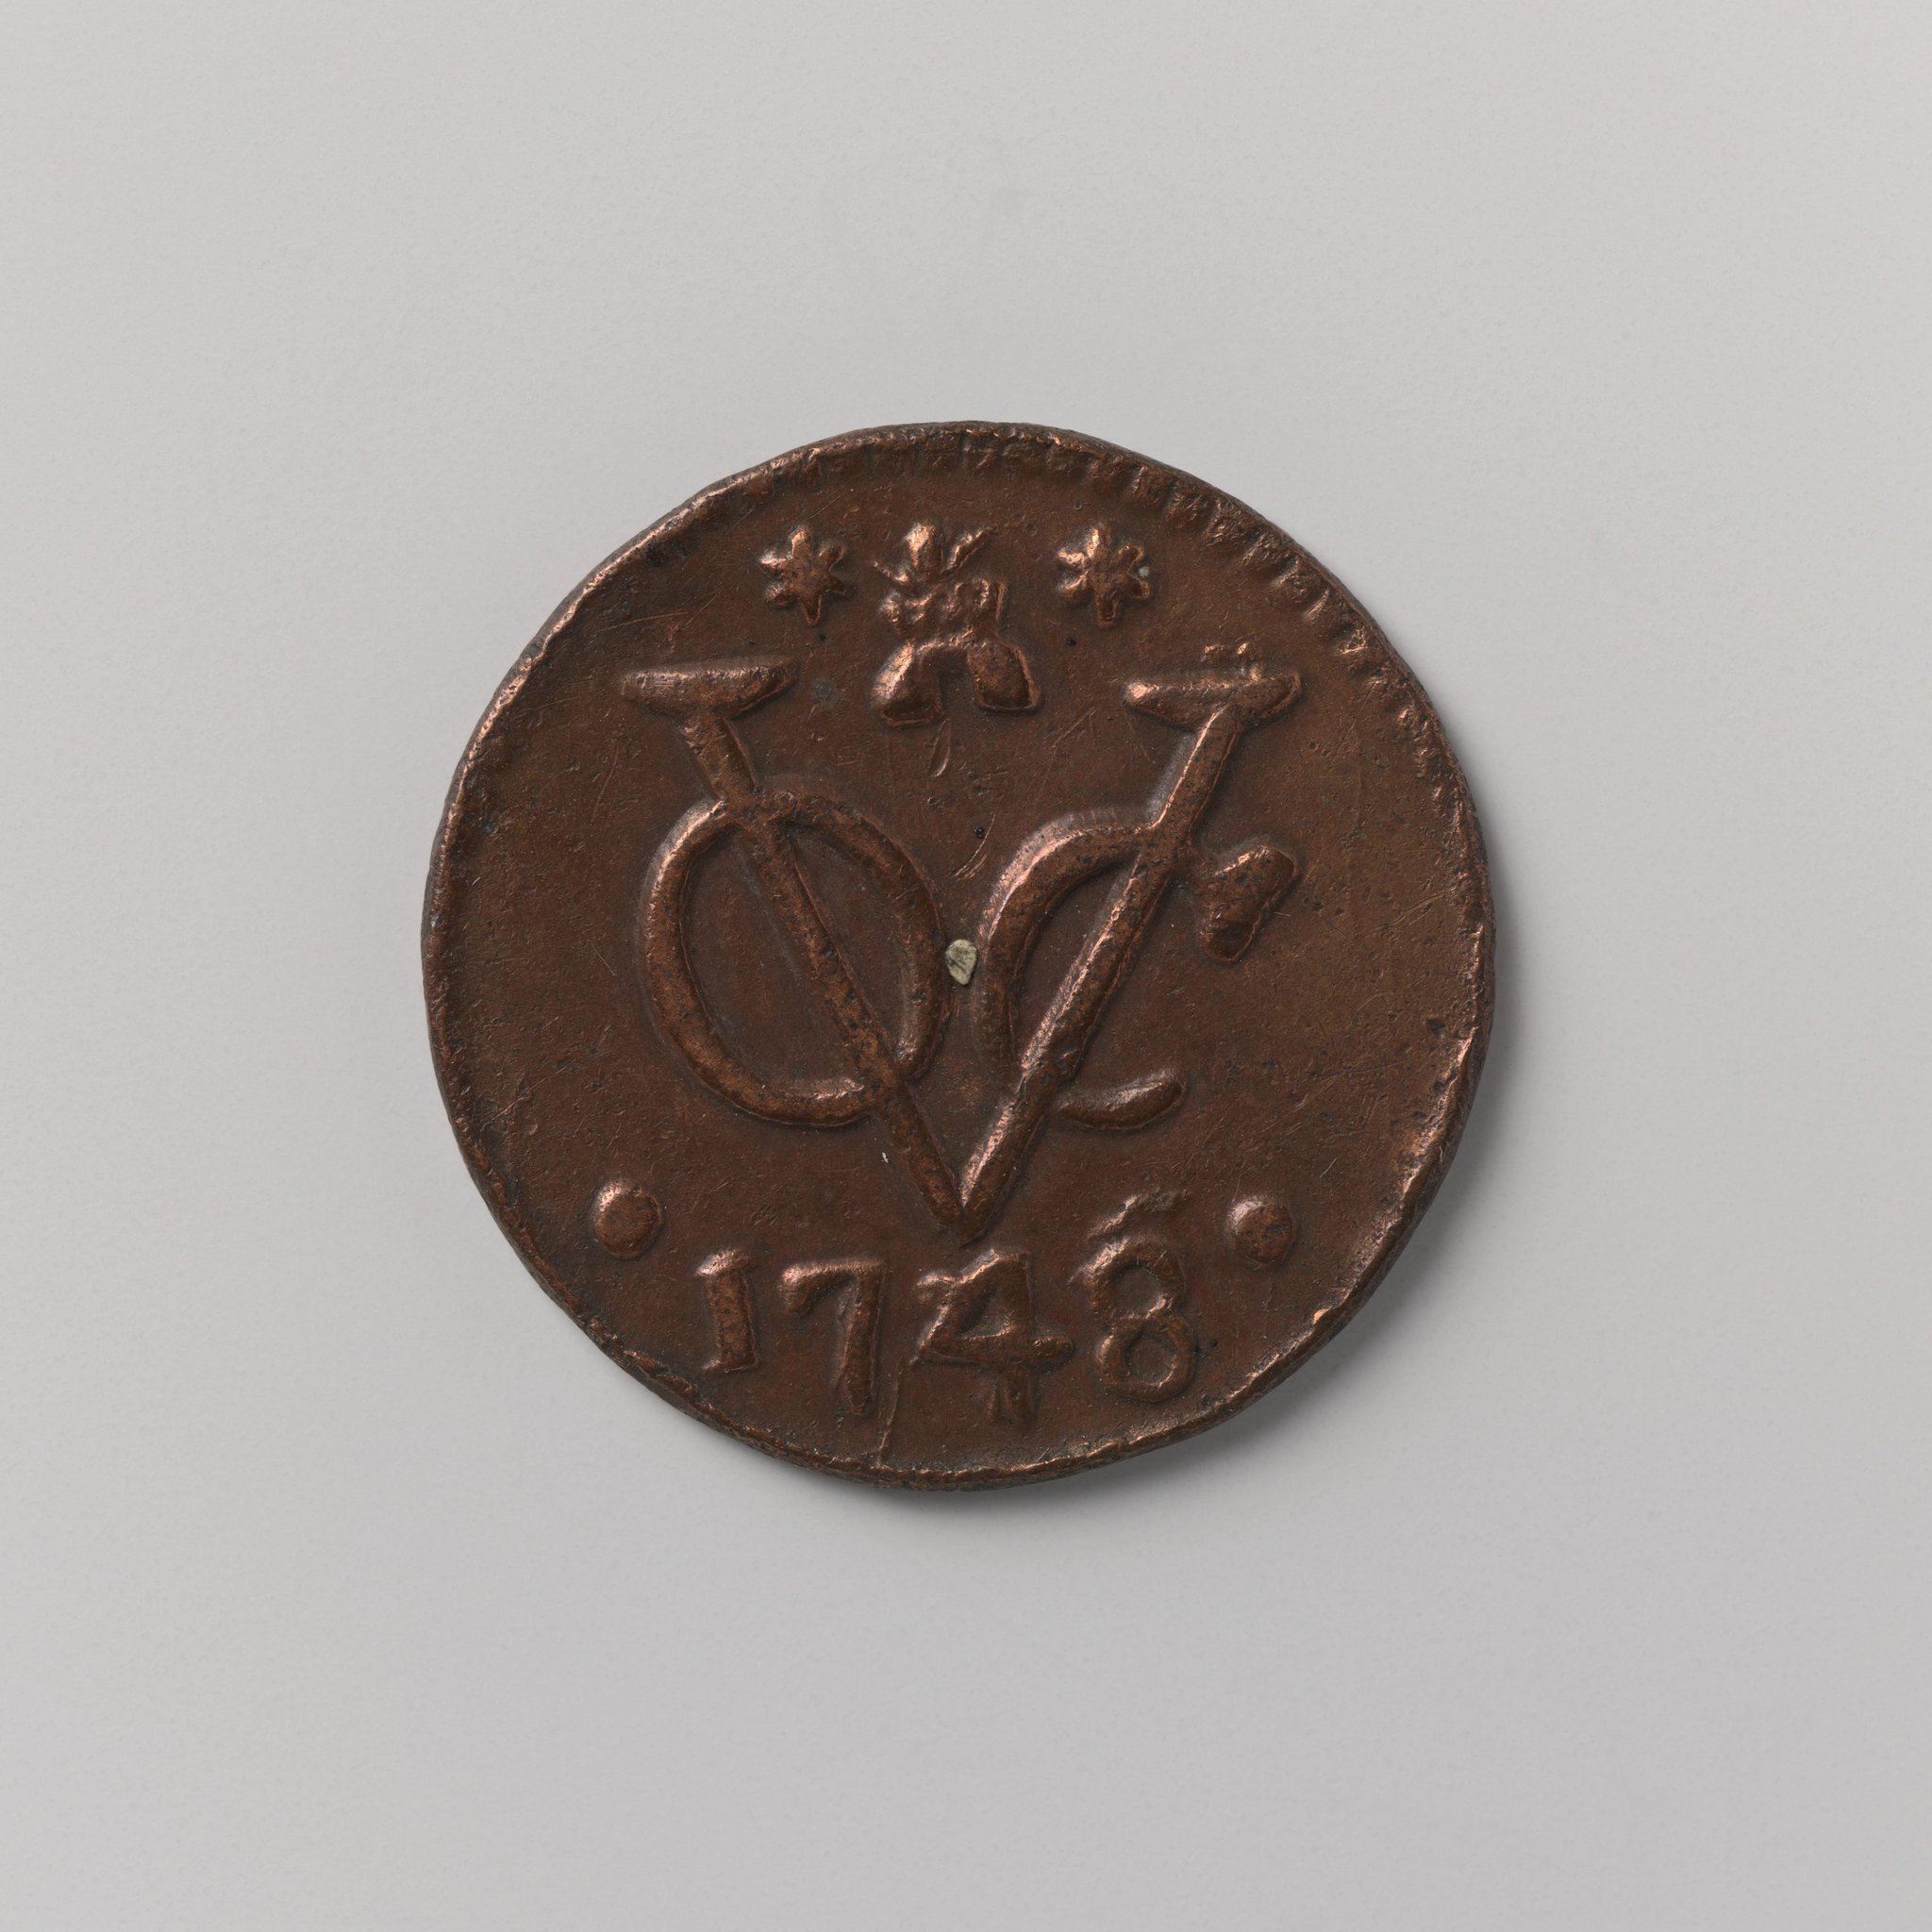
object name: coin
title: Duit van de VOC uit Zeeland, 1748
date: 1748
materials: copper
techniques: striking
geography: middelburg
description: Koperen munt. Voorzijde: gekroond wapenschild van Zeeland. Keerzijde: monogram van de VOC, waarboven muntteken en waaronder jaartal. Gladde rand.